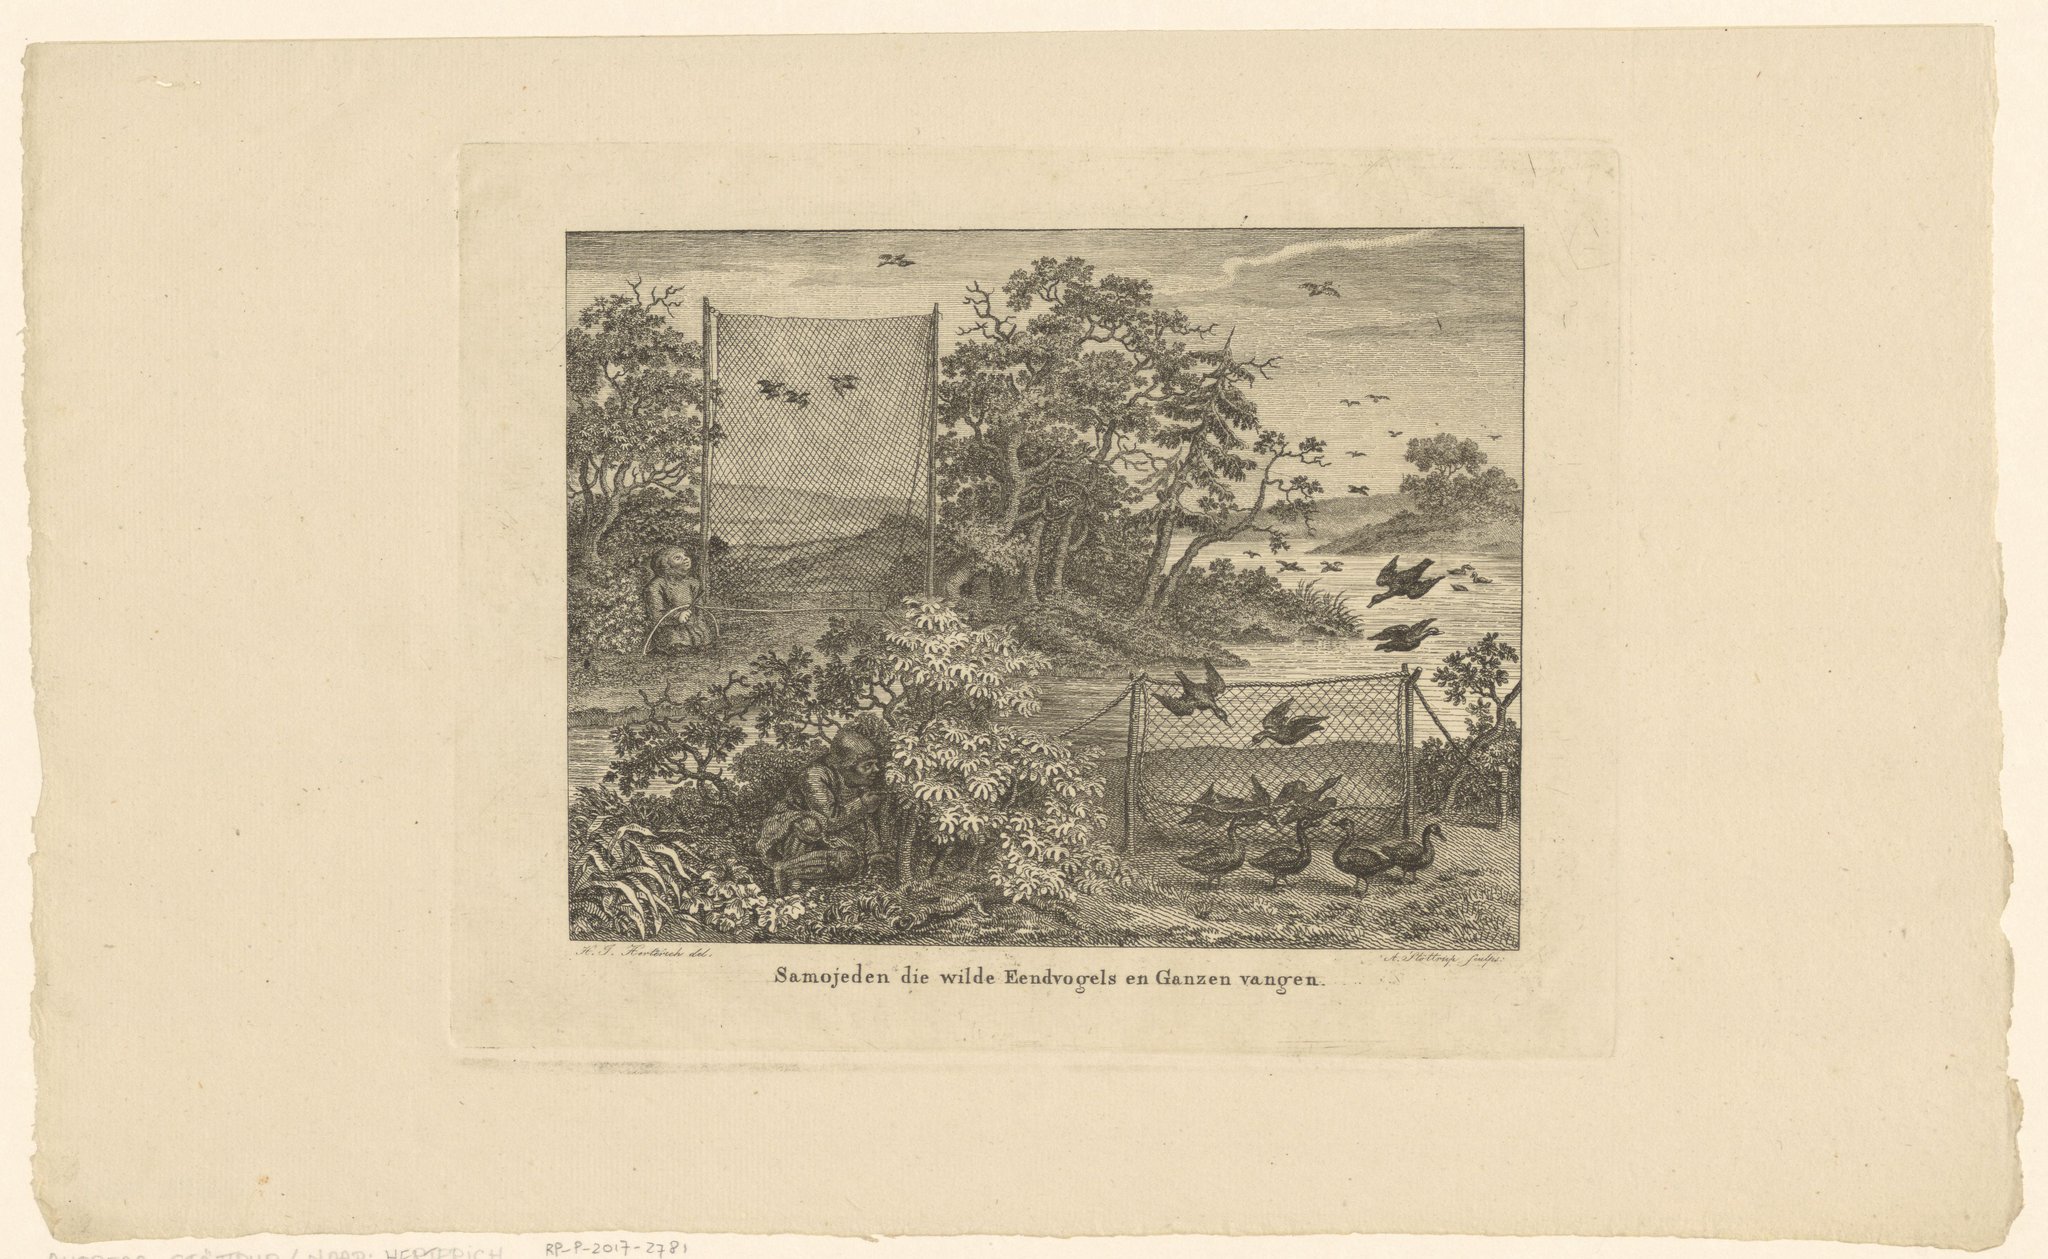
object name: print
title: Samojeden die wilde Eendvogels en Ganzen vangen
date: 1782-1812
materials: paper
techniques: etching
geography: hamburg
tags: water-birds: goose, river, bird hunting, water-birds: duck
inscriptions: collector's mark: Lugt 2228